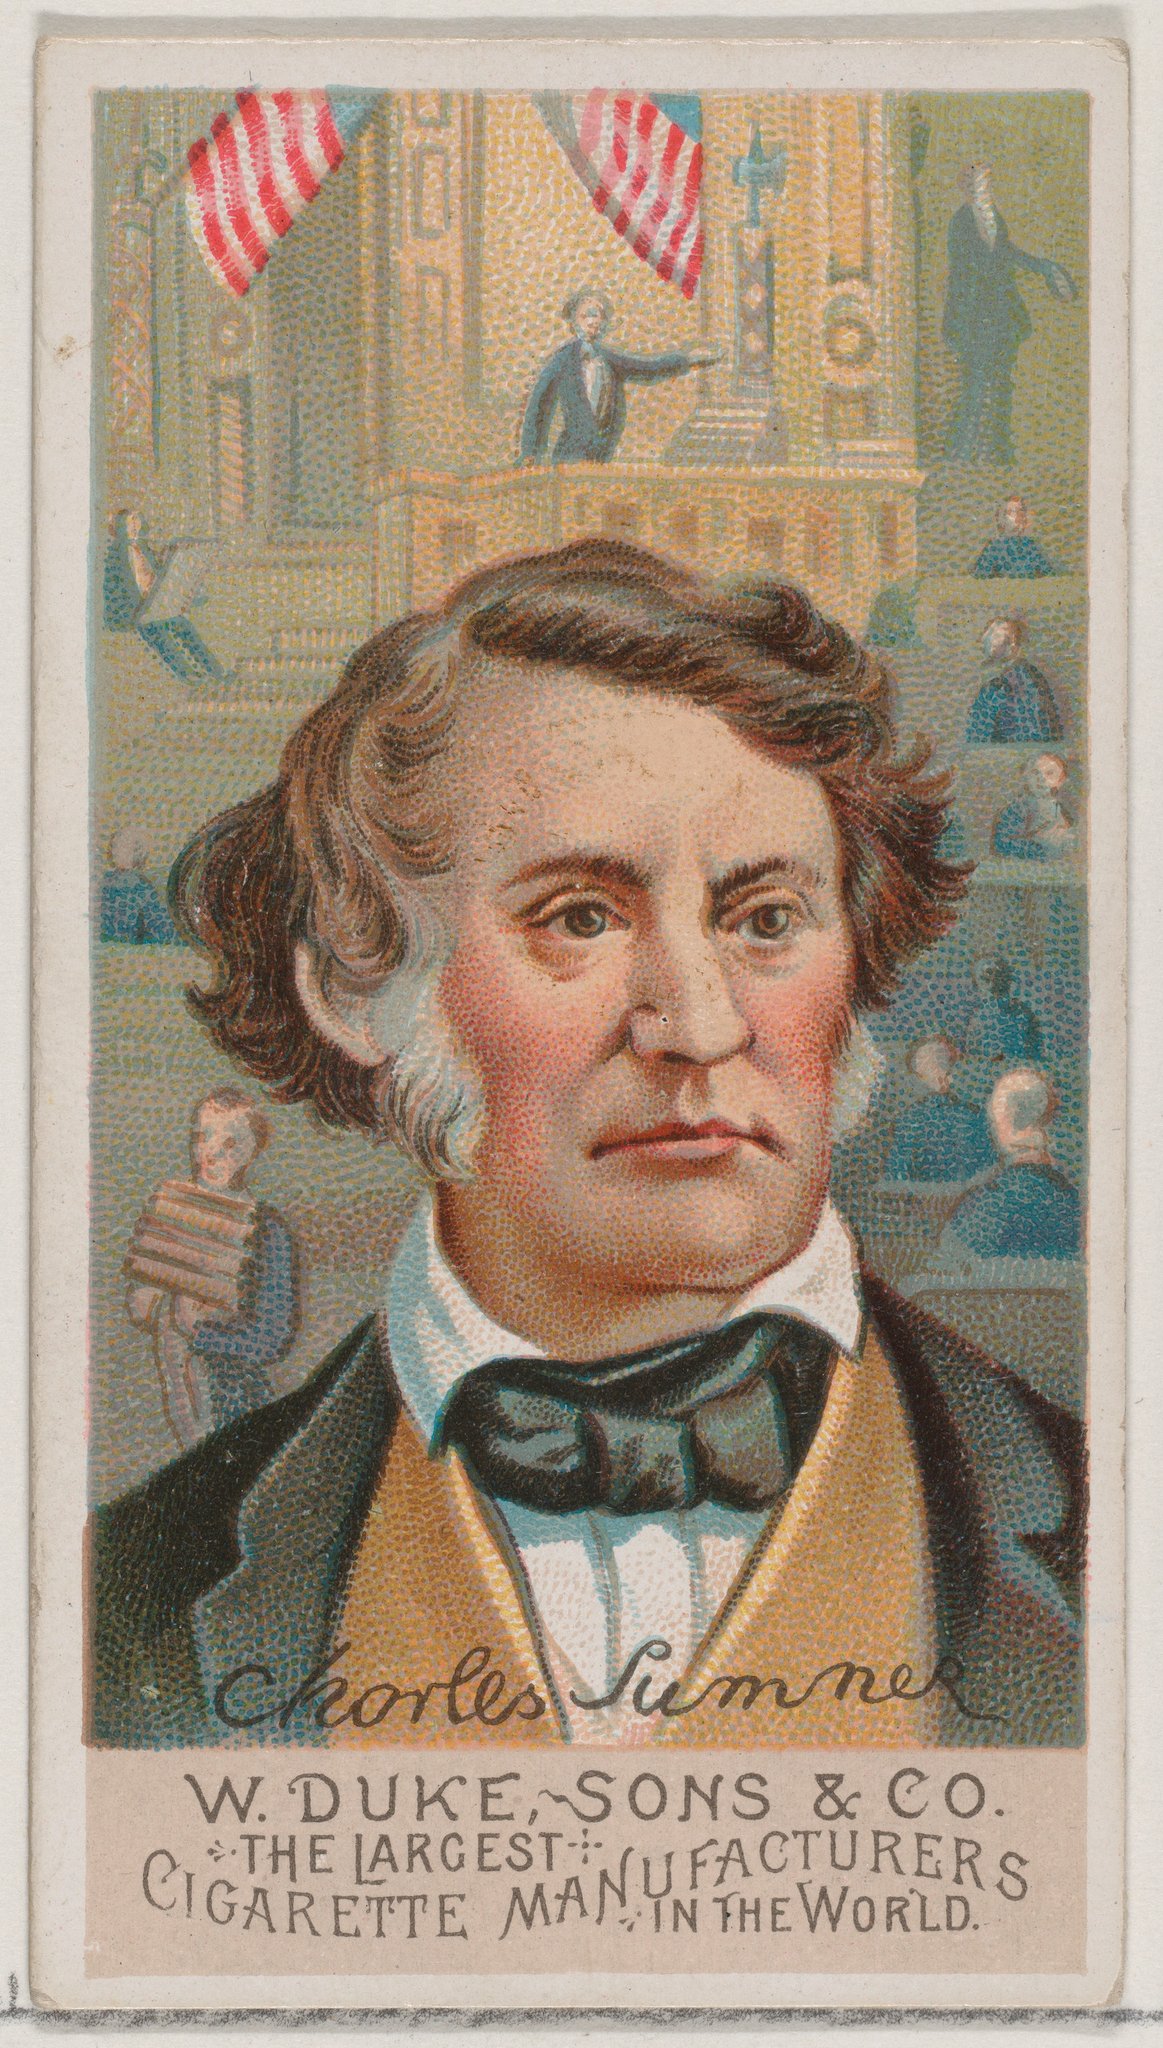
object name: print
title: Charles Sumner, from the series Great Americans (N76) for Duke brand cigarettes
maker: w. duke, sons & co.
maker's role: publisher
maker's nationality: american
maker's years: 1870-1920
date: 1888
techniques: color lithograph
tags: men